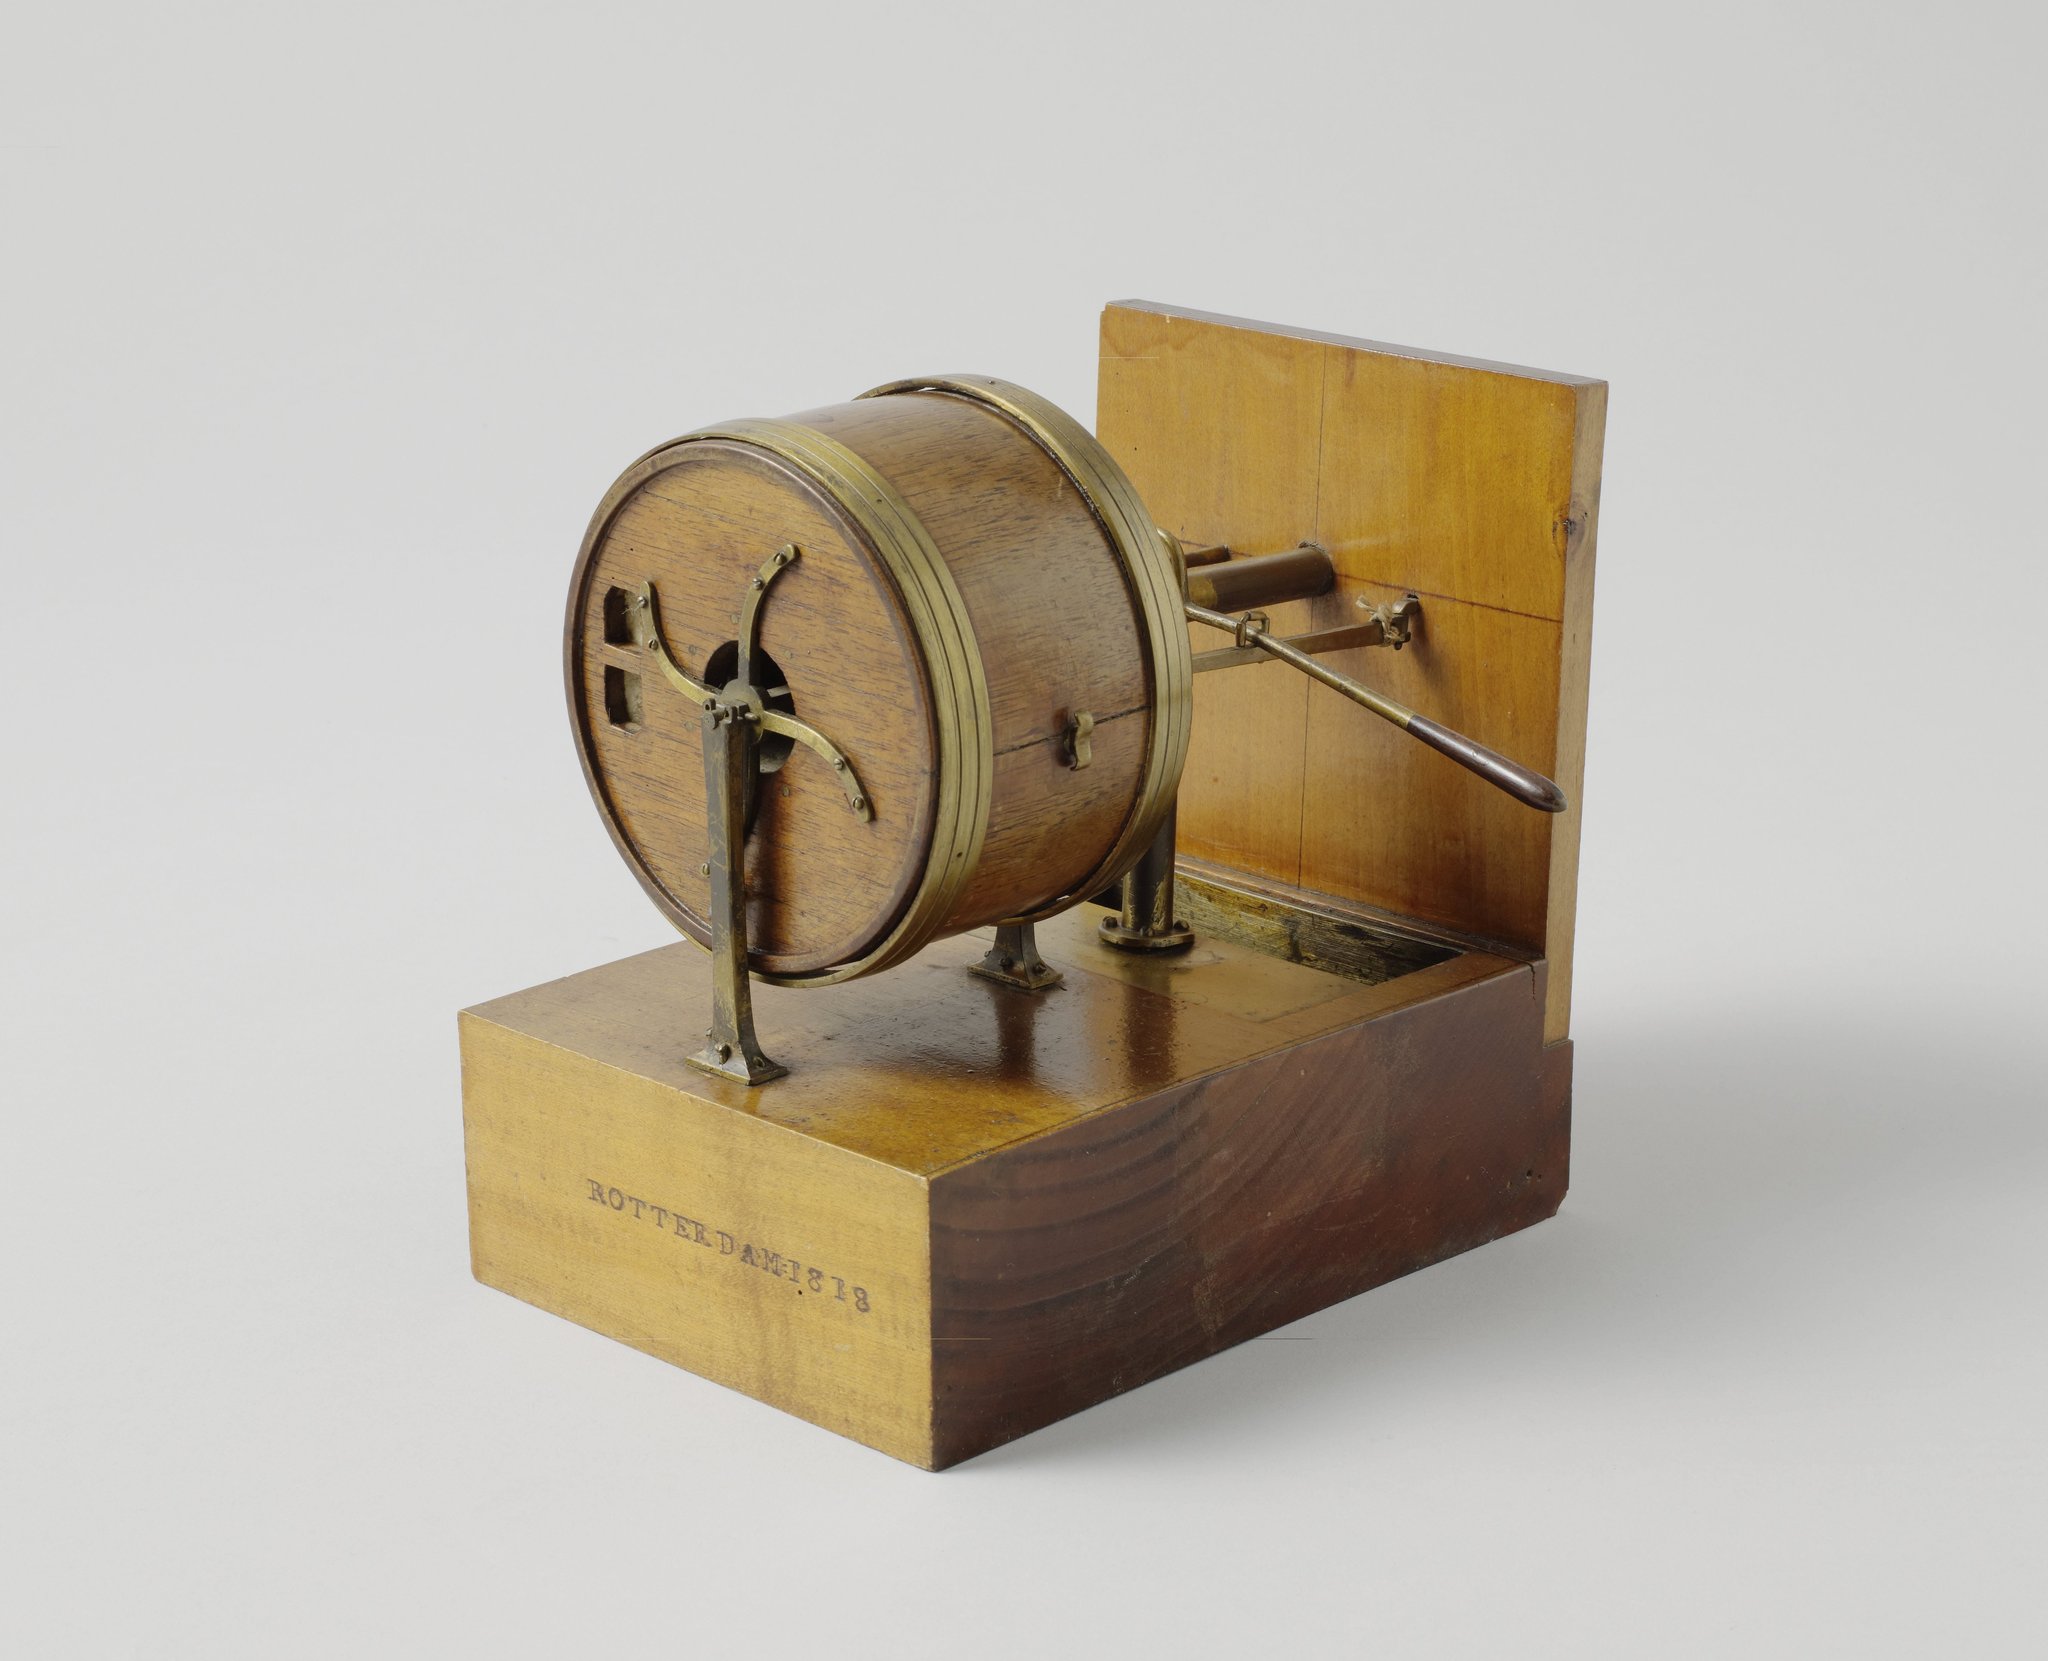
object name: demonstration model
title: Model of a Pair of Hydraulic Forge Bellows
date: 1818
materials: brass, leather, wood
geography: rotterdam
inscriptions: inscription, on the base: ‘ROTTERDAM: 1818’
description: Model van een hydraulische blaasbalg op grondplank. Het bestaat uit een vat dat horizontaal is opgehangen in twee vorken en door middel van een hendel een kwart cirkel om zijn as heen en weer gedraaid kan worden. De ruimte binnenin is door een buis in de as-richting omgevormd tot een eindeloze cirkel, die weer eindig gemaakt wordt door een in de langsrichting geplaatst schot tussen buiten- en binnenwand boven op de buis. Aan de ene kant is aan weerszijden van dit schot een ingaand ventiel met zeemleren klep aangebracht, aan de andere zijde uitgaande ventielen, waarop een ventilatiepijp is aangesloten. Als nu het vat voor de helft gevuld wordt met water, wordt de ruimte die voor lucht overblijft in twee compartimenten gedeeld: door het vat heen en weer te draaien worden die afwisselend groter en kleiner, omdat het wateroppervlak horizontaal blijft. Zo wordt de luchtstroom tot stand gebracht. De ventilatiepijp is gebogen zodat het uiteinde gelijk loopt met de draaiings-as, en aansluit op een vaste pijp in een wand achter de blaasbalg. In de vloer tussen vat en wand is een dubbele watertank aangebracht: één deel is van boven afgesloten en verbonden met het andere door een gleuf onder in het schot; het afgesloten deel staat met een verticale pijp in verbinding met de ventilatiepijp.